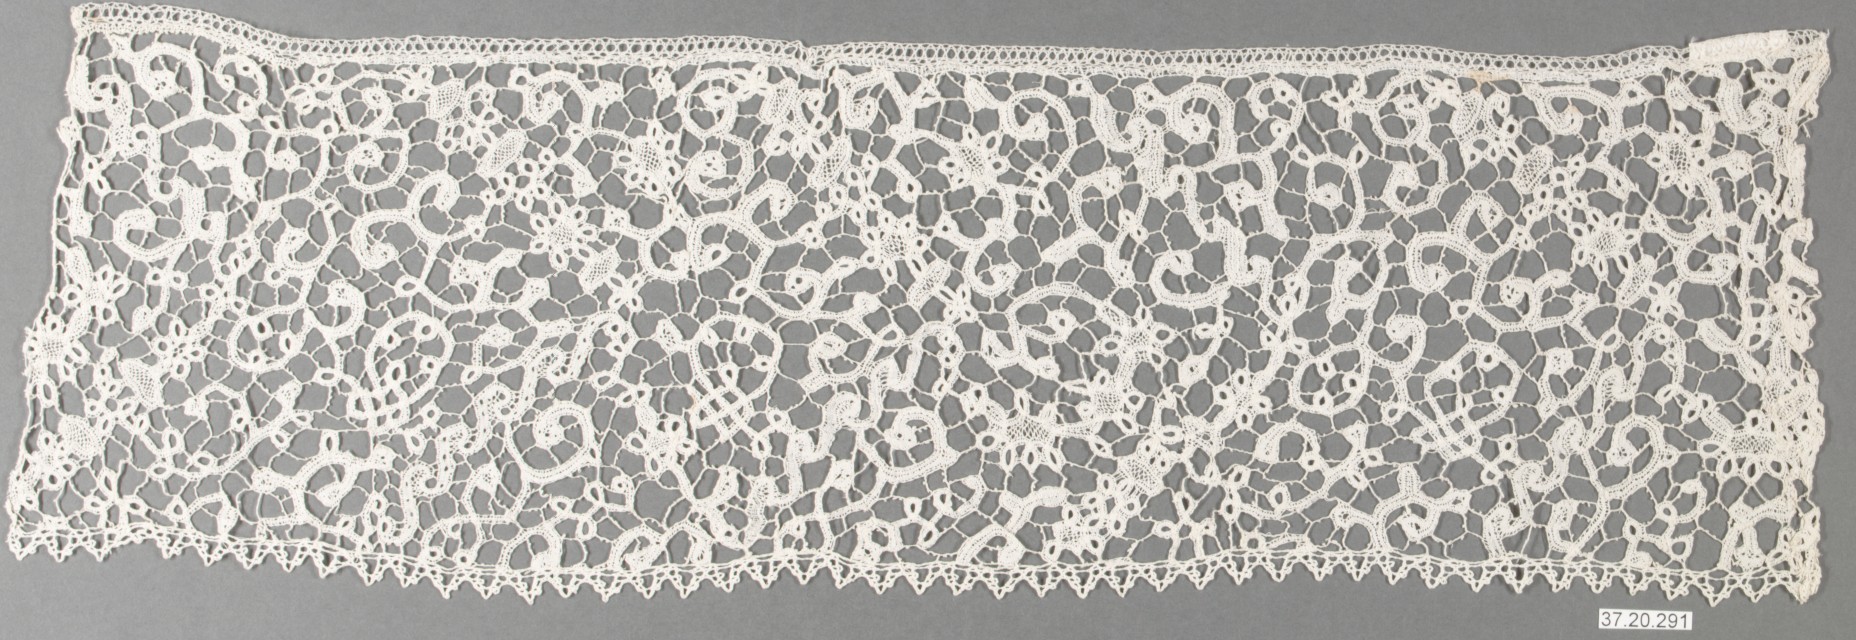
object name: fragment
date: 1601-1700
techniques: lace